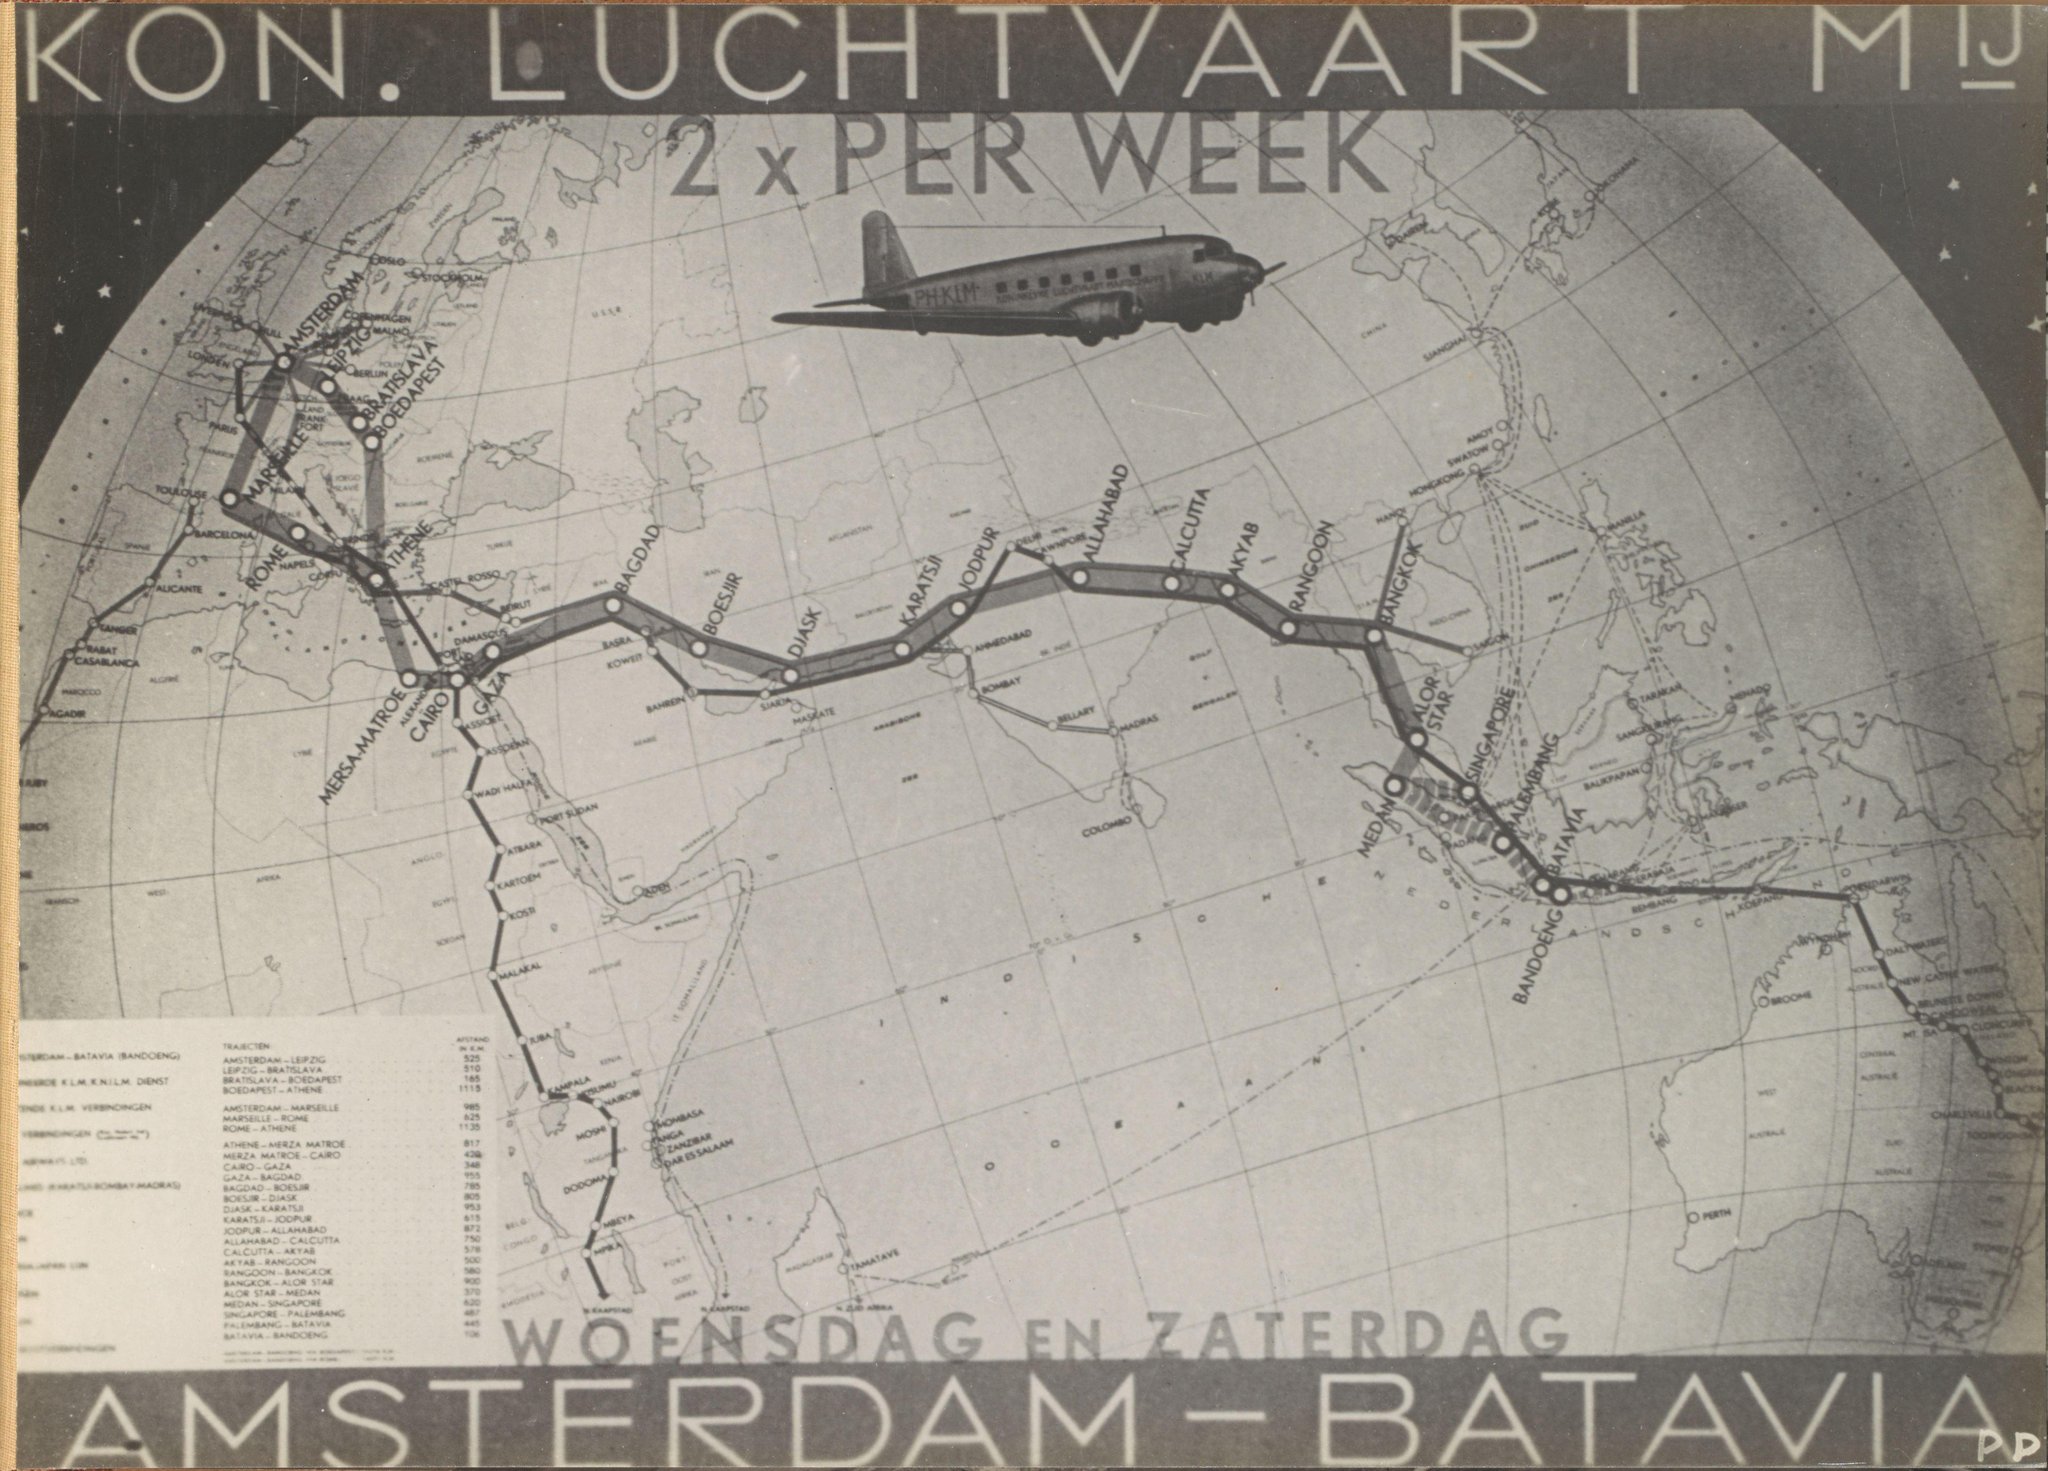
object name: photograph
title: Routeschema van de vlucht naar Nederlands-Indië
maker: Anonymous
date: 1929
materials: cardboard, paper, photographic support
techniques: gelatin silver print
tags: aircraft, aeroplane, airborne traffic, aviation, travelling; tourism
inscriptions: inscription: ‘PP’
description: Albumblad met een foto van (vermoedelijk) een affiche van de tweewekelijkse KLM-vlucht van Amsterdam naar Batavia. Onderdeel van Herdenkingsalbum van de Indië-lijn van de KLM, deel I.